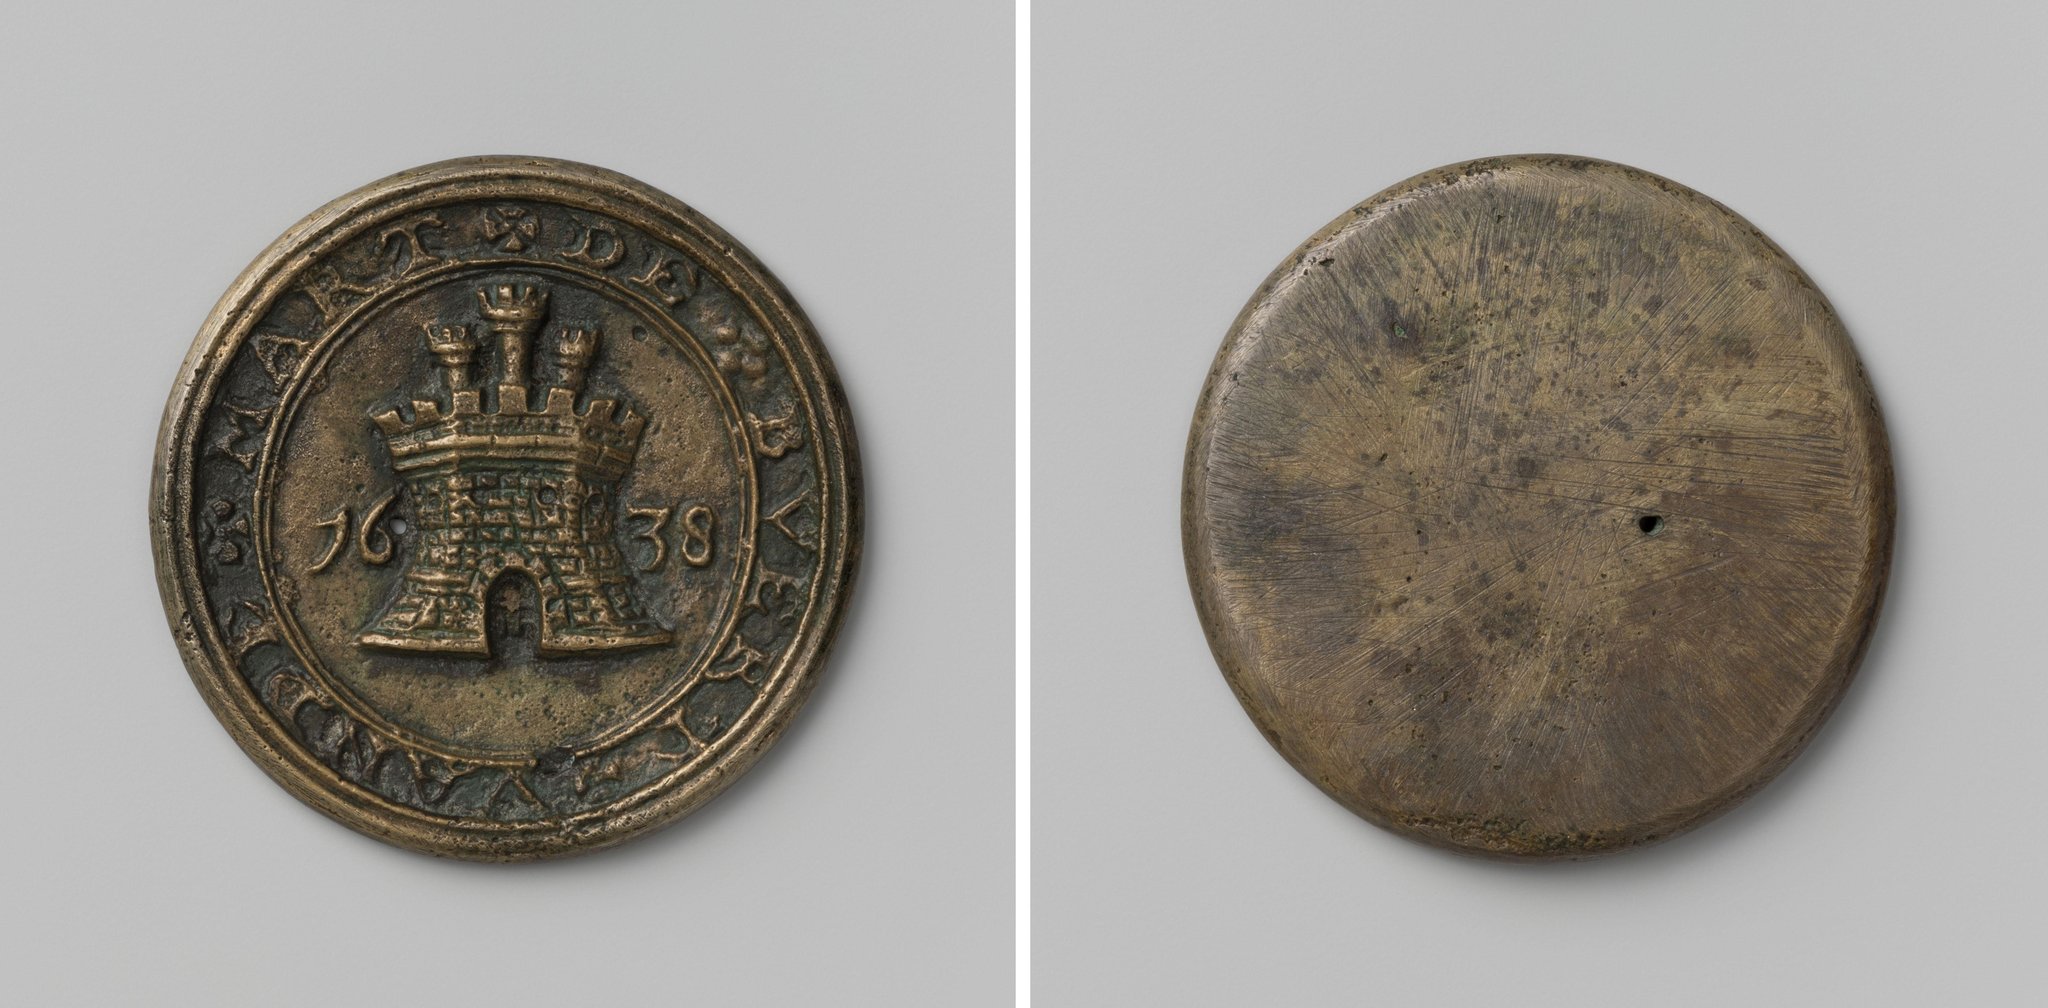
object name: buurtpenning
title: Buurt van de Groenmarkt te 's-Gravenhage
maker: Anonymous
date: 1638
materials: brass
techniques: casting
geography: the hague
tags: dagelijkse groenmarkt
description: Eenzijdige messing penning. Voorzijde: burcht tussen jaartal binnen omschrift. Keerzijde: blanco.